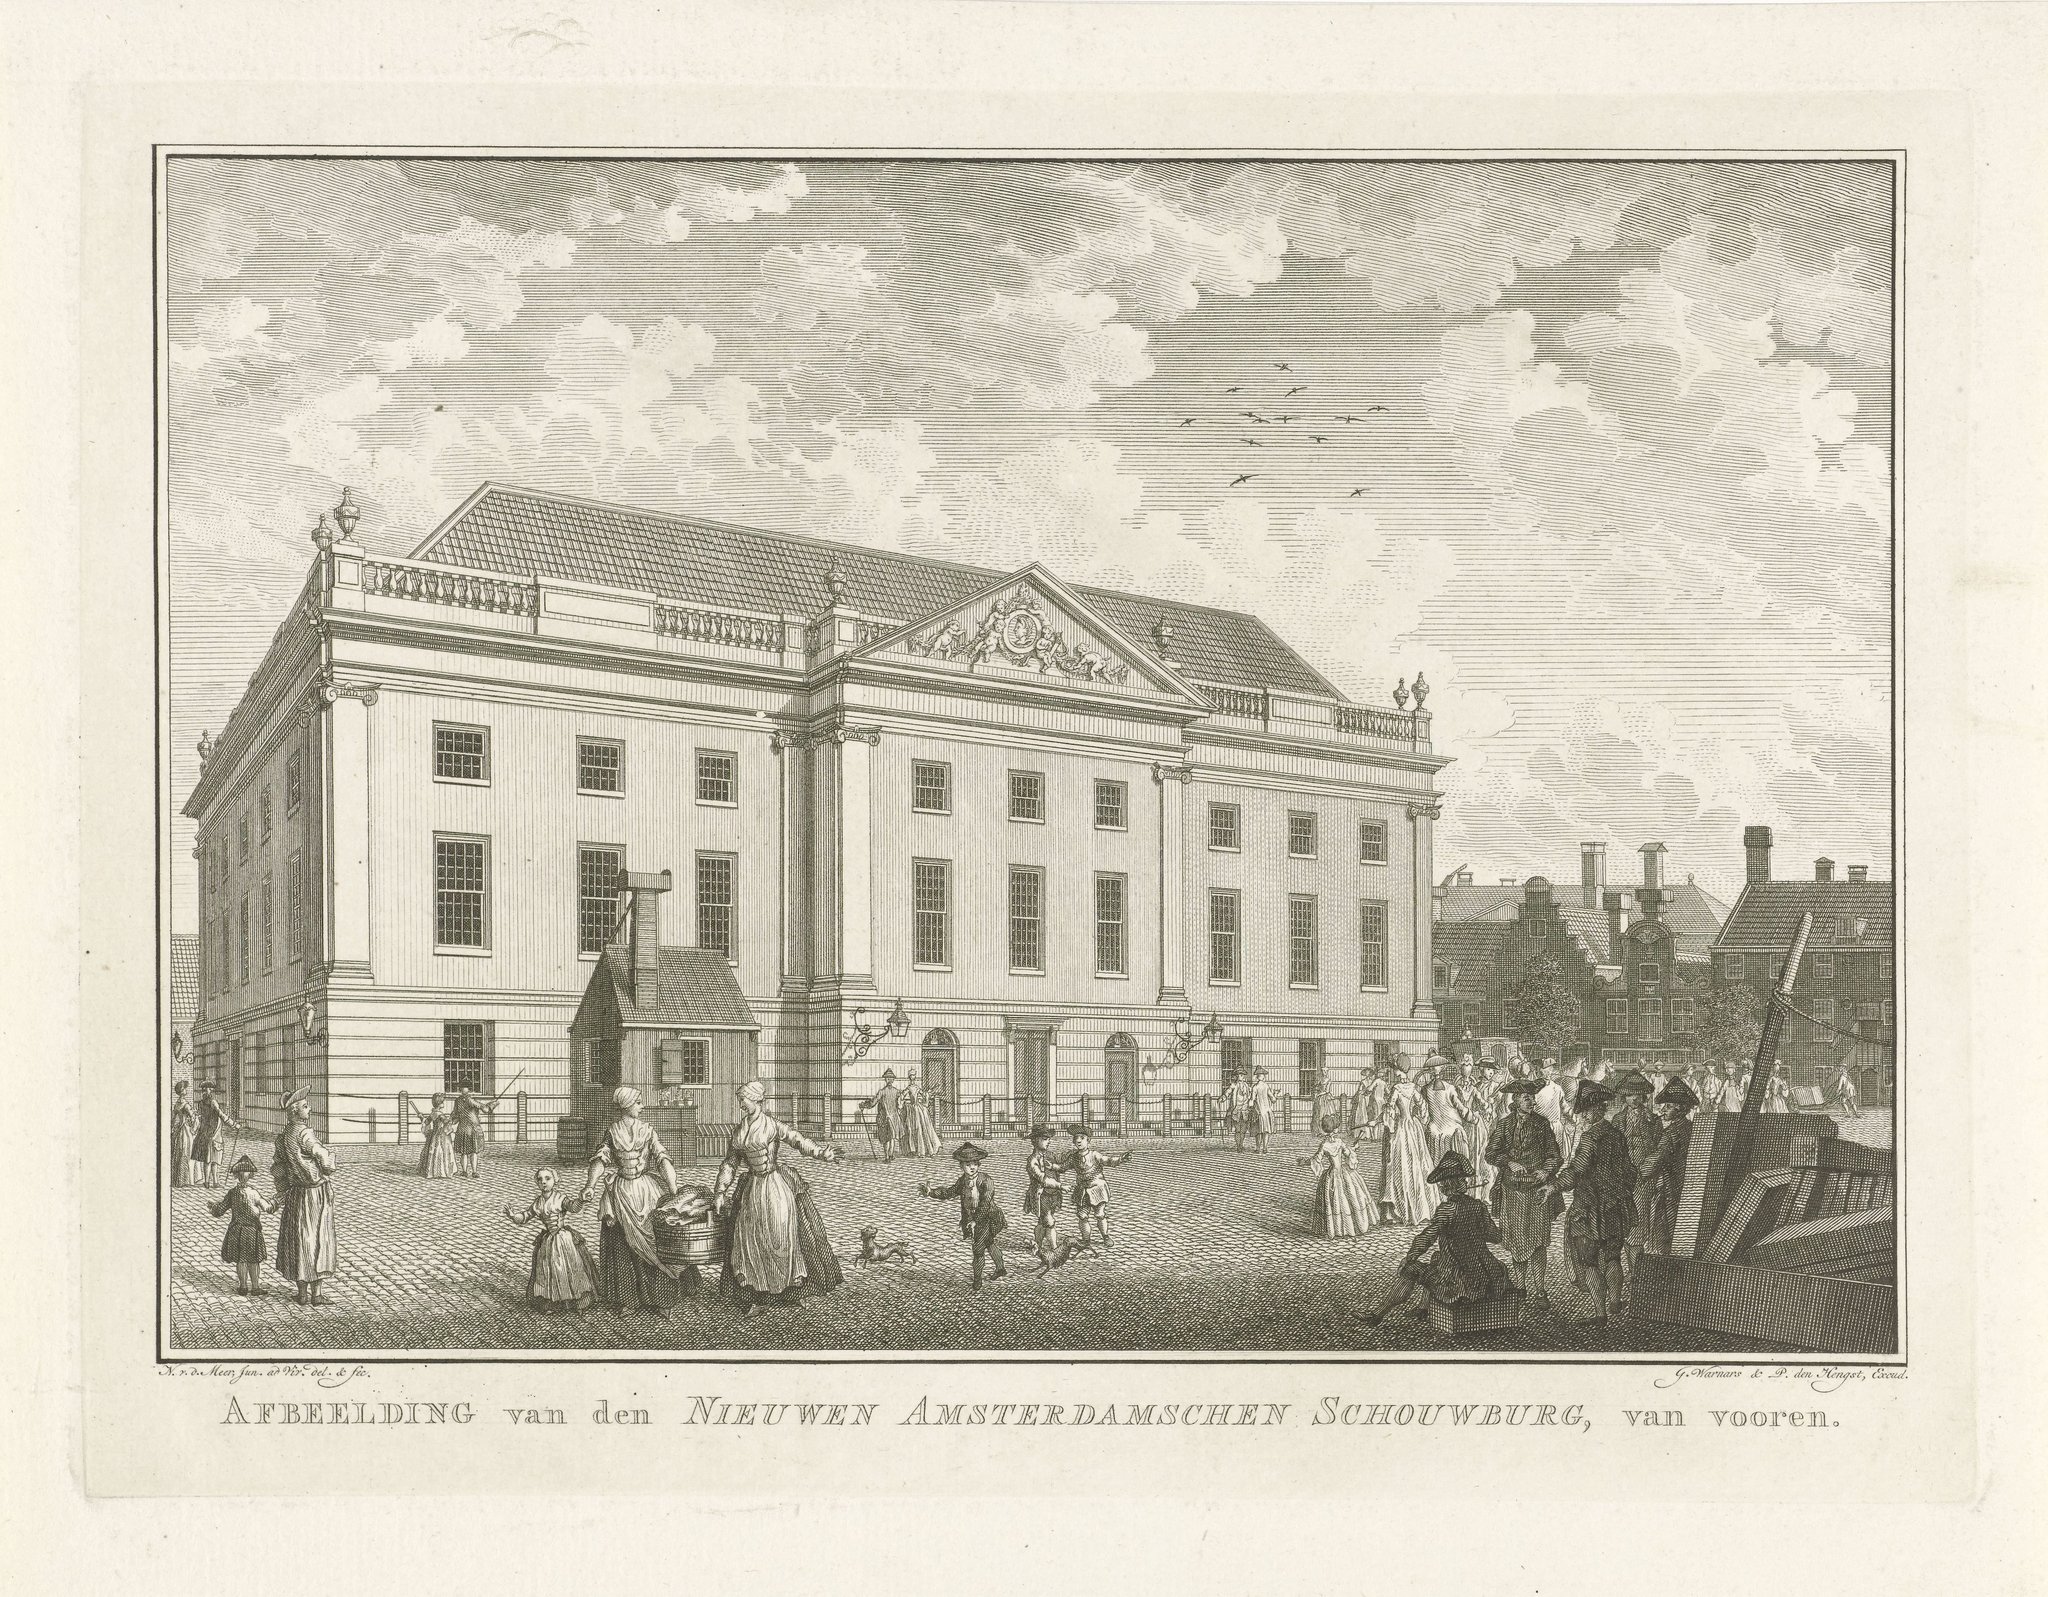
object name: book illustration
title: Gezicht op de voorzijde van de schouwburg aan het Leidseplein te Amsterdam, 1774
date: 1774-1775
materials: paper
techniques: engraving, etching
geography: amsterdam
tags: theatre (building), square, place, circus, etc. (+ city(-scape) with figures, staffage)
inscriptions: collector's mark: Lugt 2228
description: Prent ook gebruikt in: Historie van den nieuwen Amsterdamschen schouwburg. Met fraaije afbeeldingen. Amsterdam: Gerrit Warnars en Petrus den Hengst, 1775.* * Twee uitgaven uit zelfde jaar. Prent komt in ieder geval voor in een van de twee uitgaven.